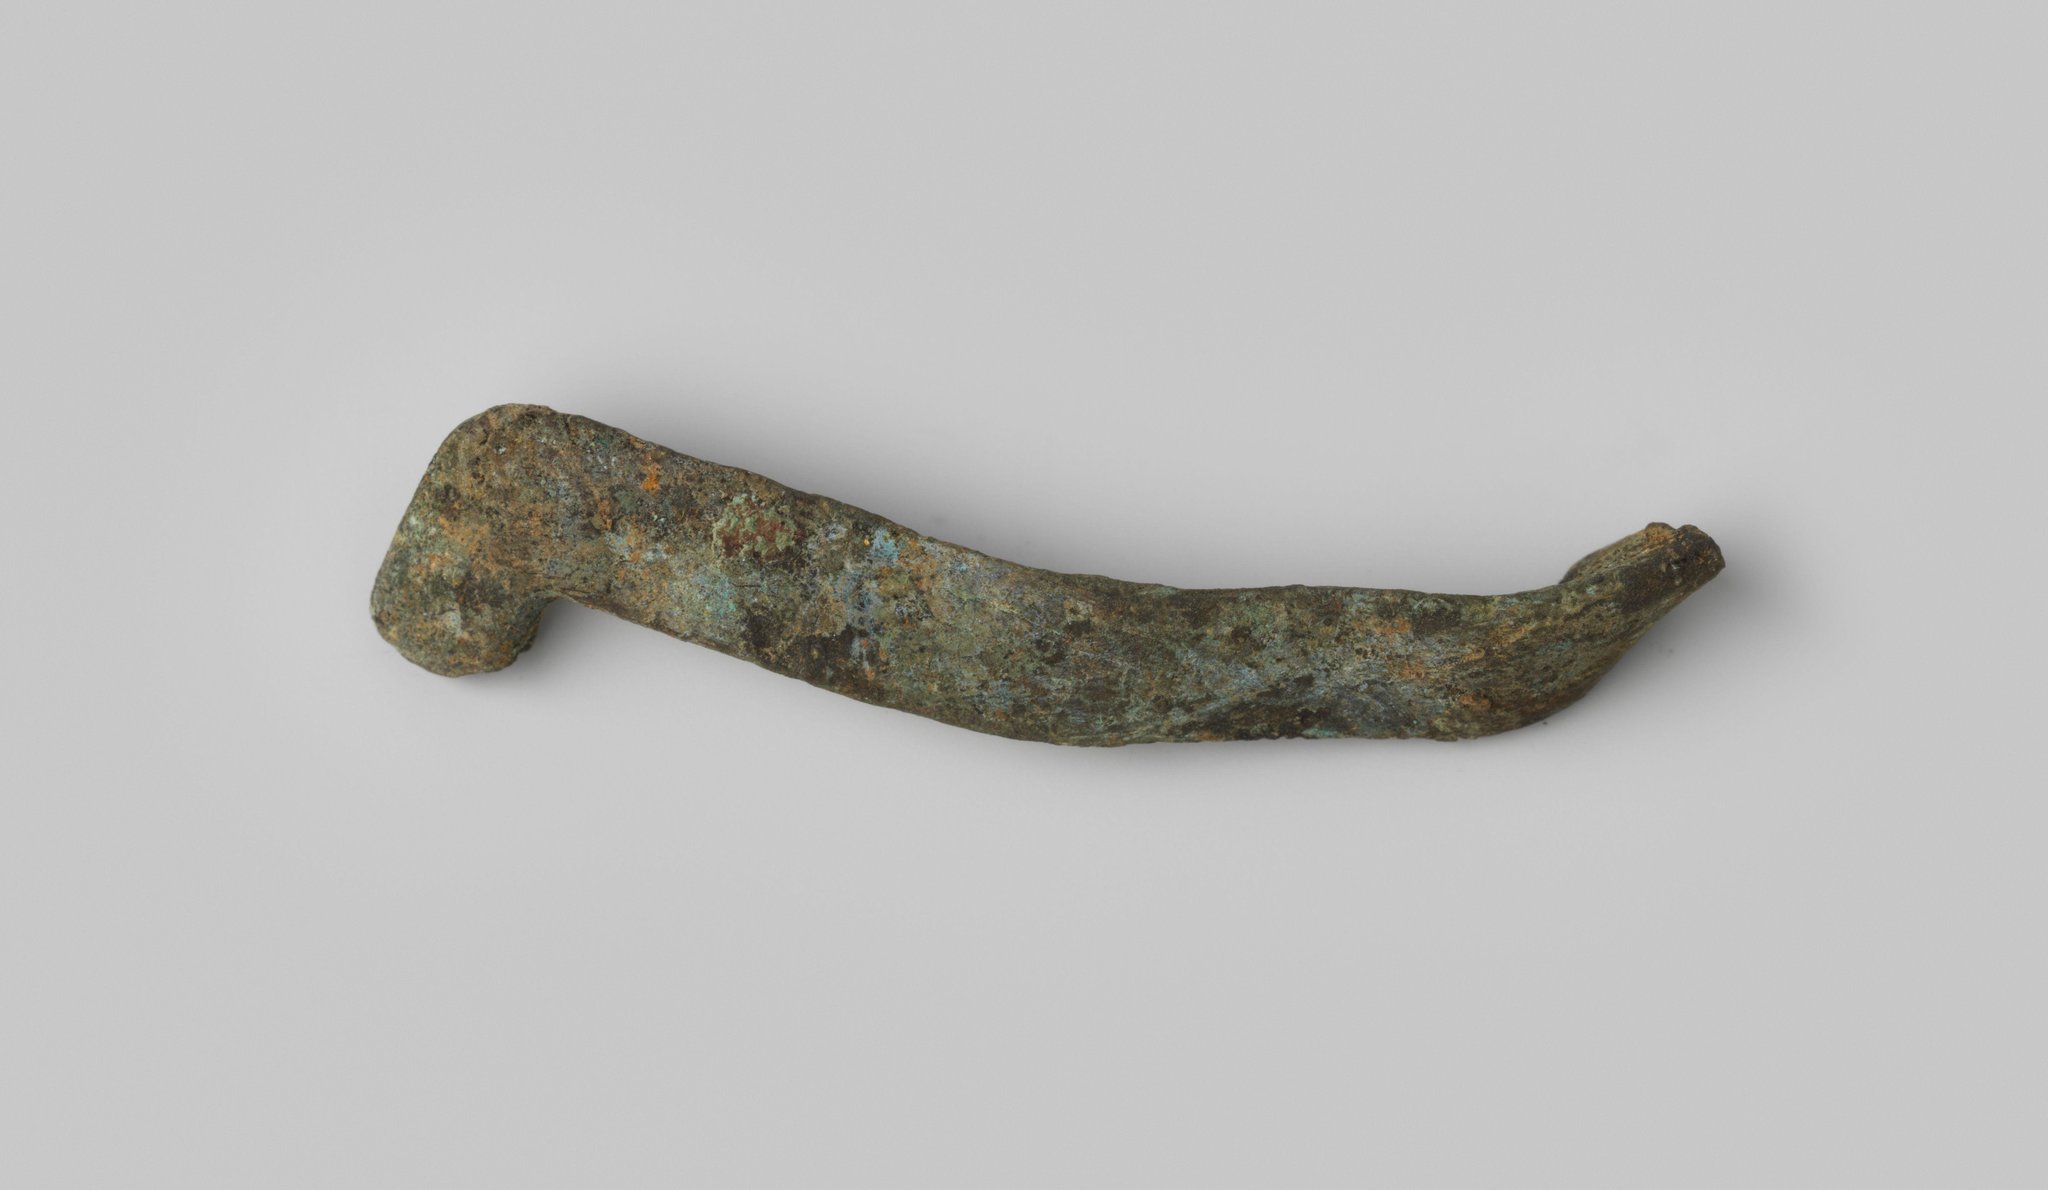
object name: belt buckle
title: Fragment riemgesp uit het wrak van de Oost-Indiëvaarder Hollandia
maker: Anonymous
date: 1700-1743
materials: copper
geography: netherlands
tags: verenigde oostindische compagnie, hollandia (schip), annet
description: Rectangular, fragm of ring, id. NG 1980-27H2852, belt buckle.